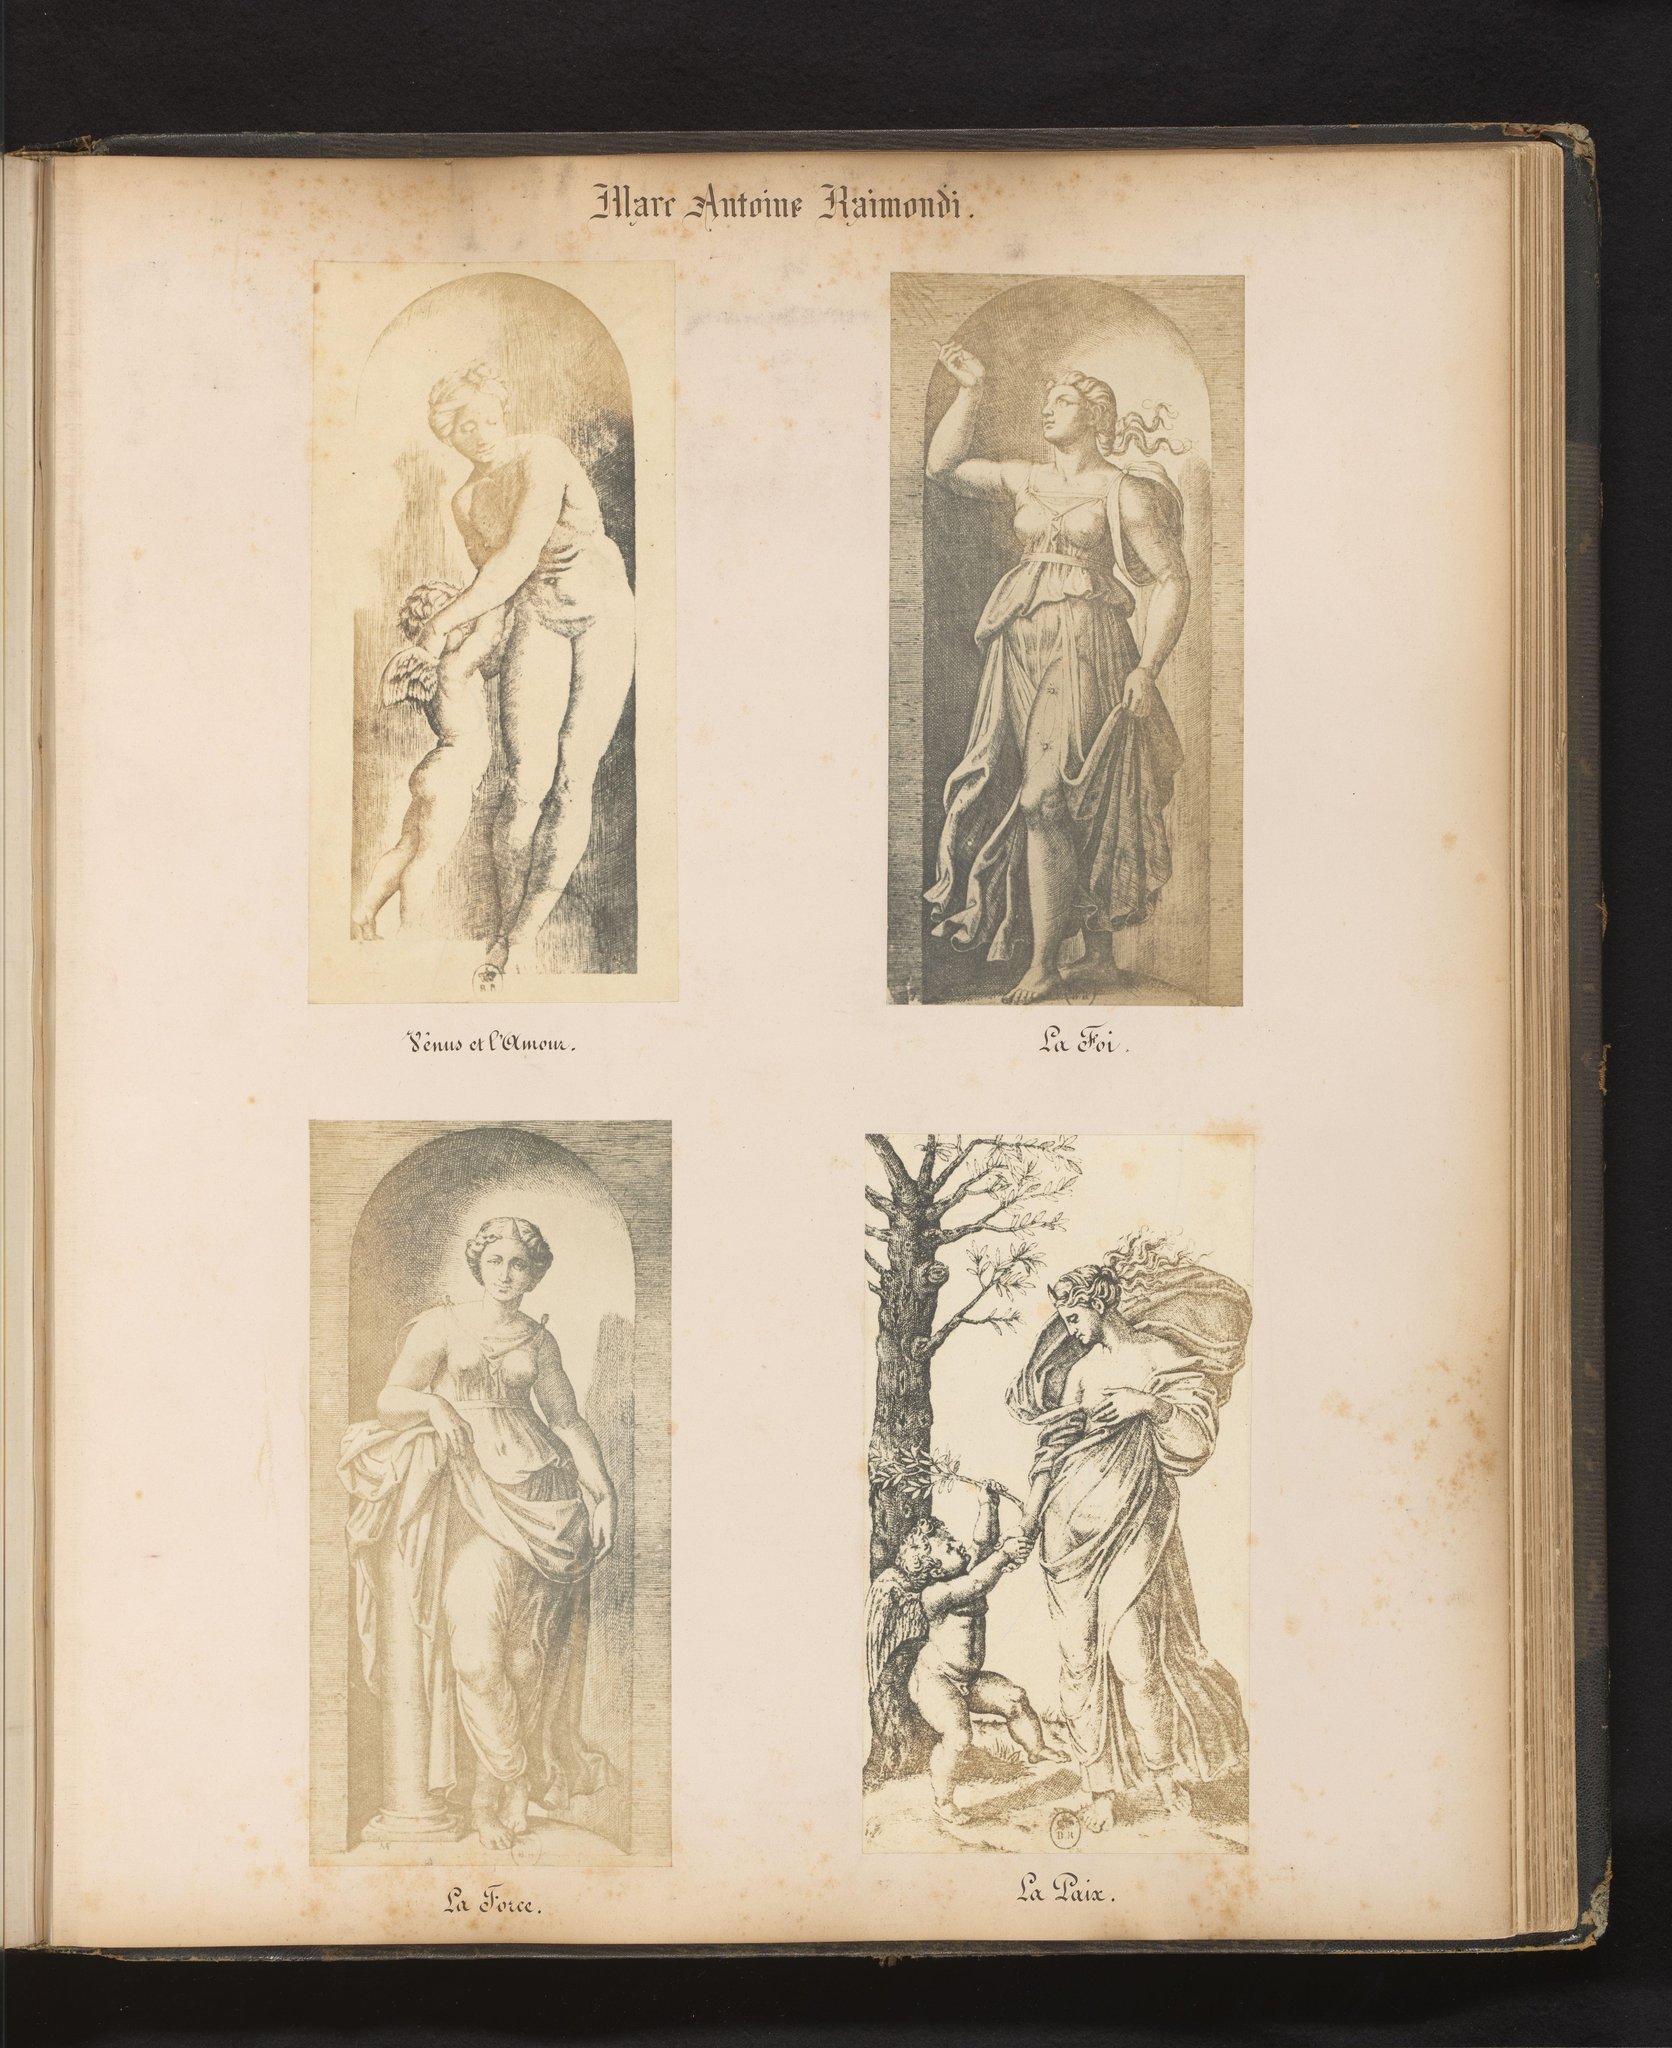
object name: page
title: Fotoreproductie van een gravure van Venus en Cupido door Marcantonio Raimondi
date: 1848-1853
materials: photographic support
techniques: salted paper print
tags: venus and cupid (cupid not being mere attribute)